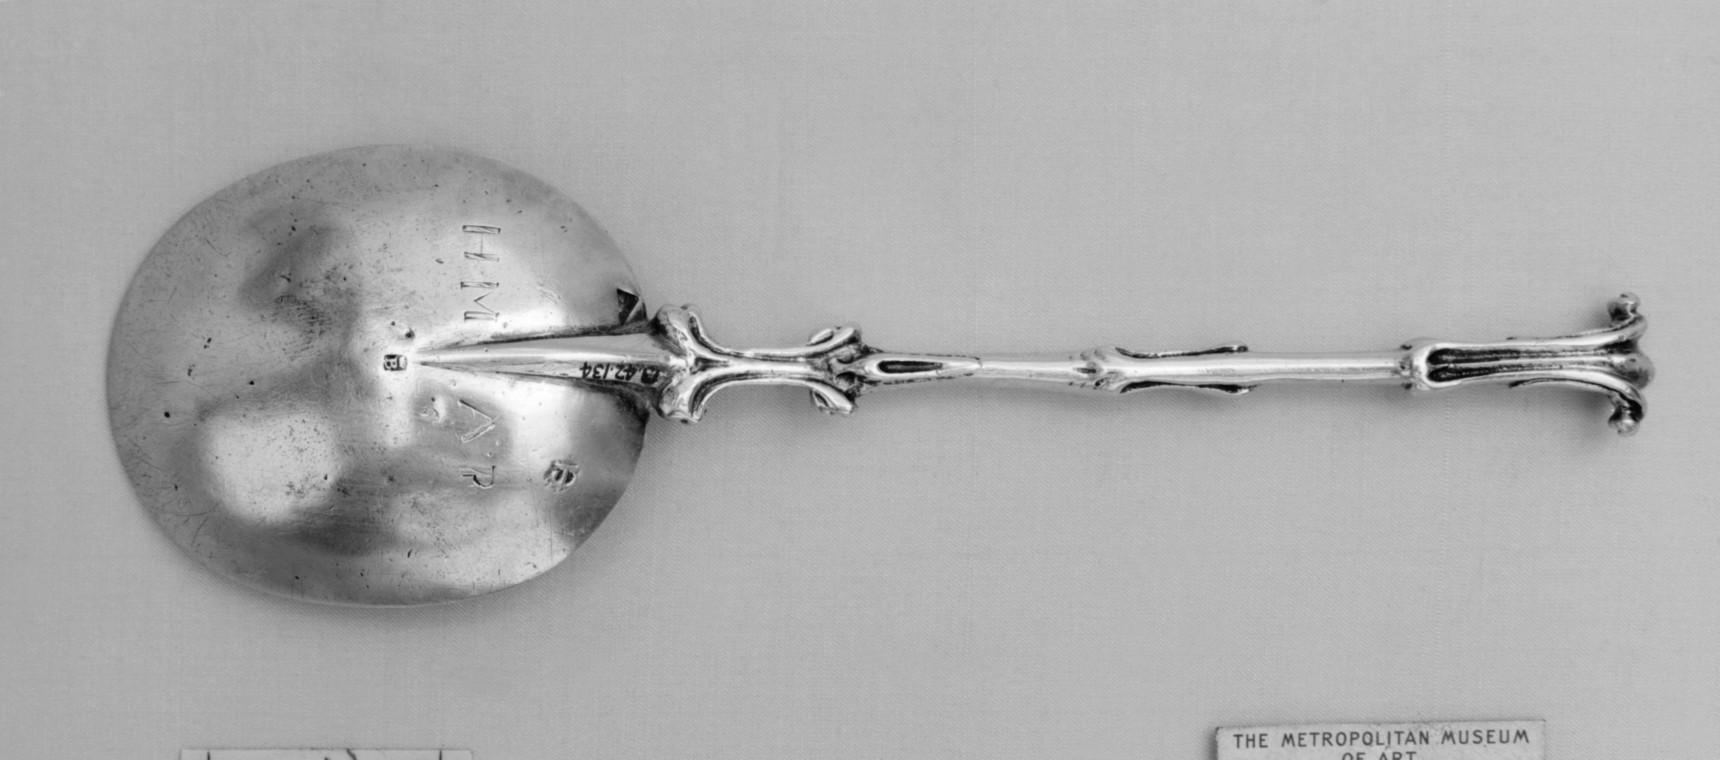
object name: spoon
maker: hendrick jansen sympa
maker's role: maker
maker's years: 1657-1669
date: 1660-1669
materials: silver